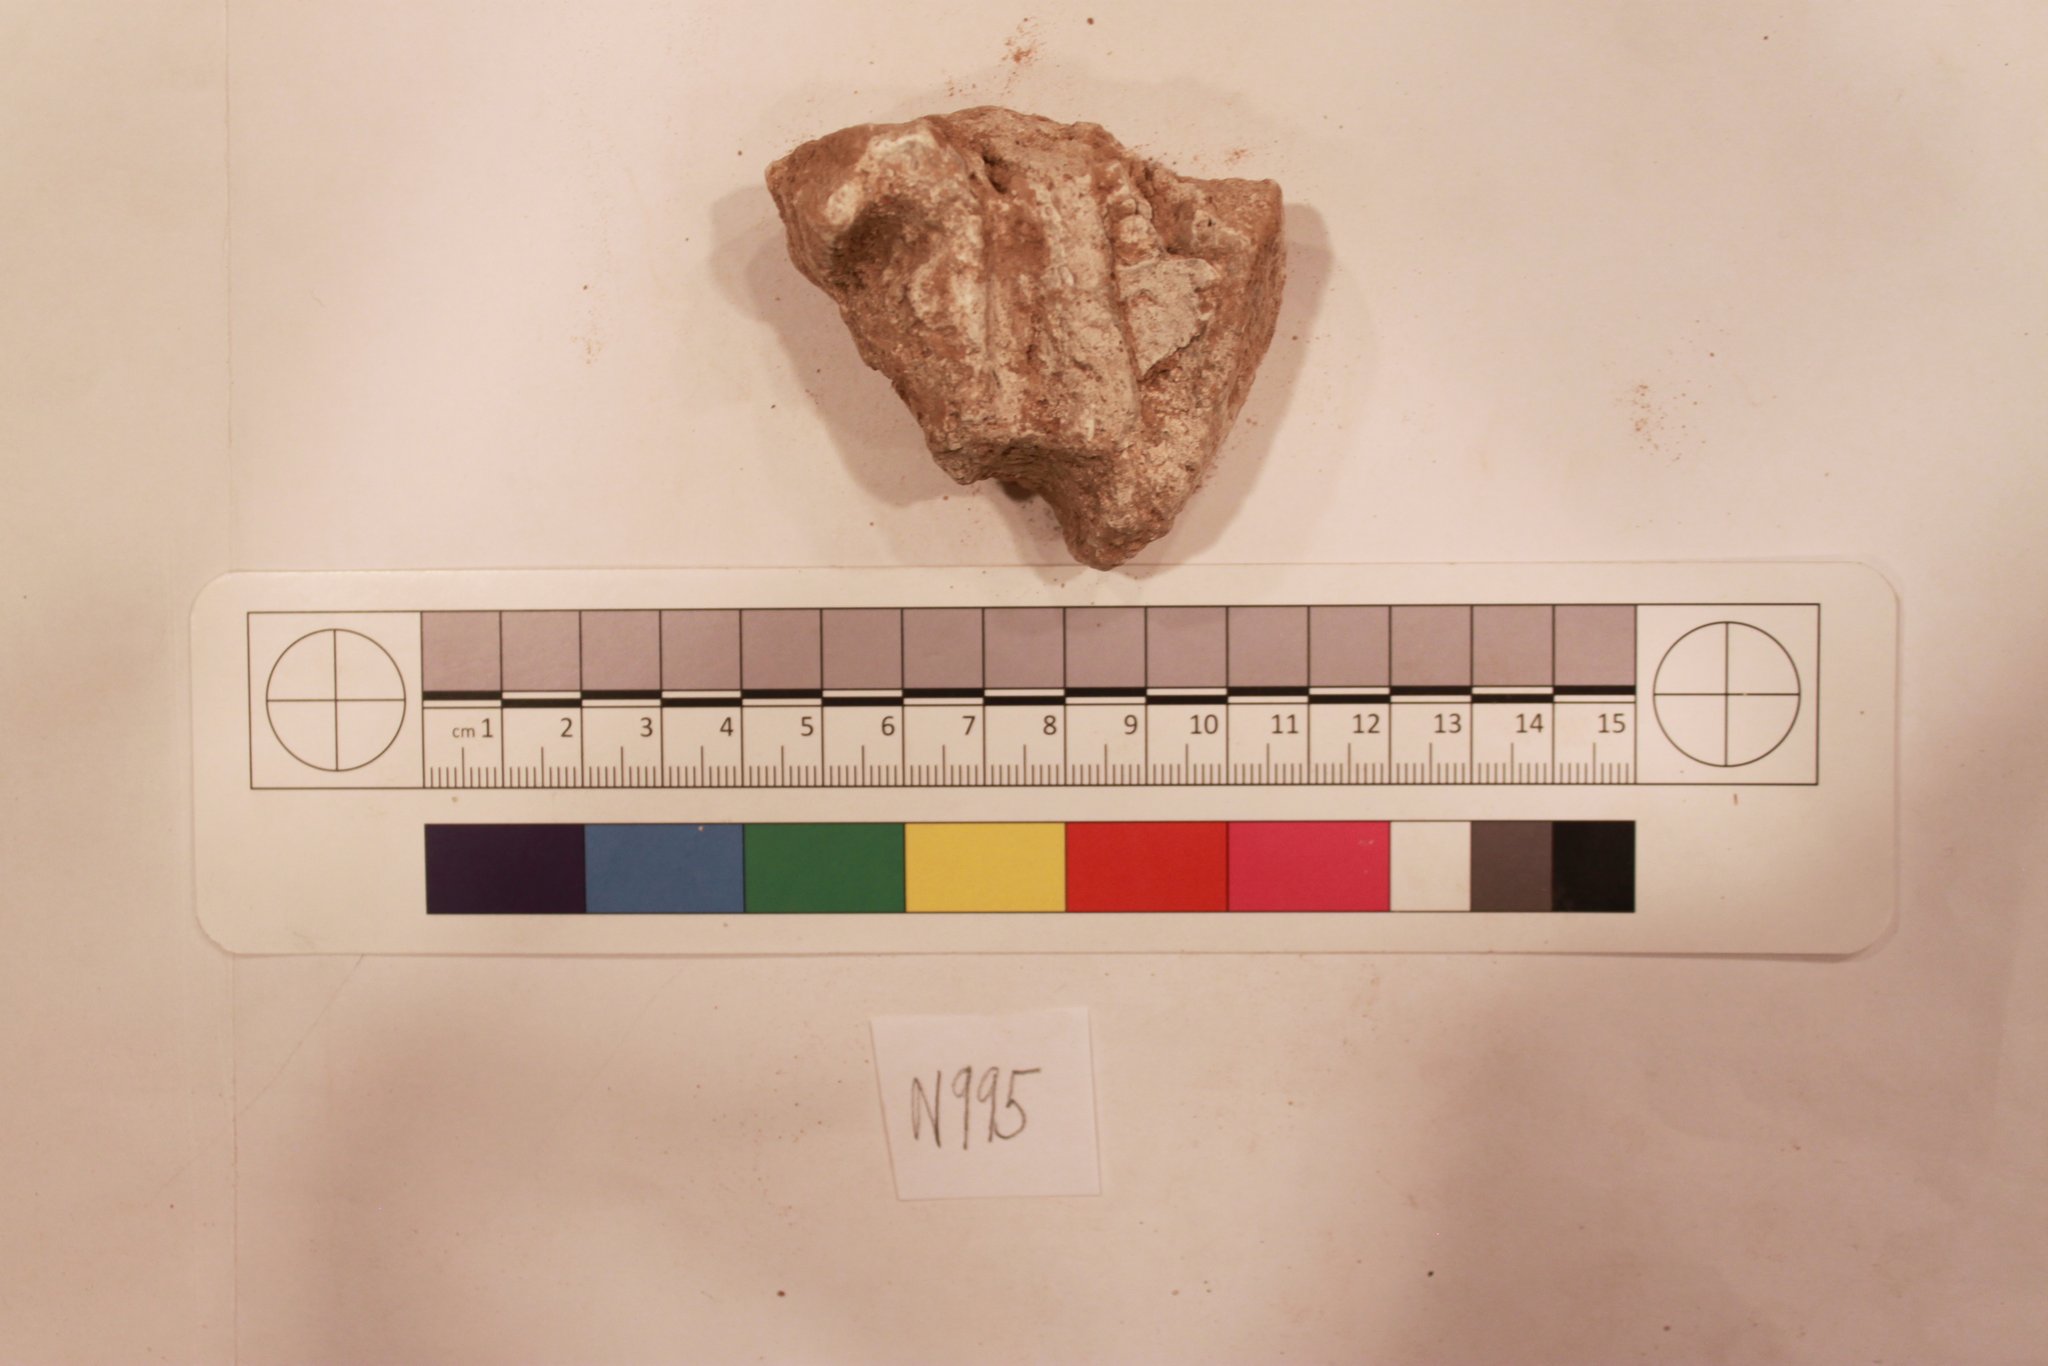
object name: fragment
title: Stucco Fragment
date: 701-1200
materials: plaster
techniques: carving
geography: iran